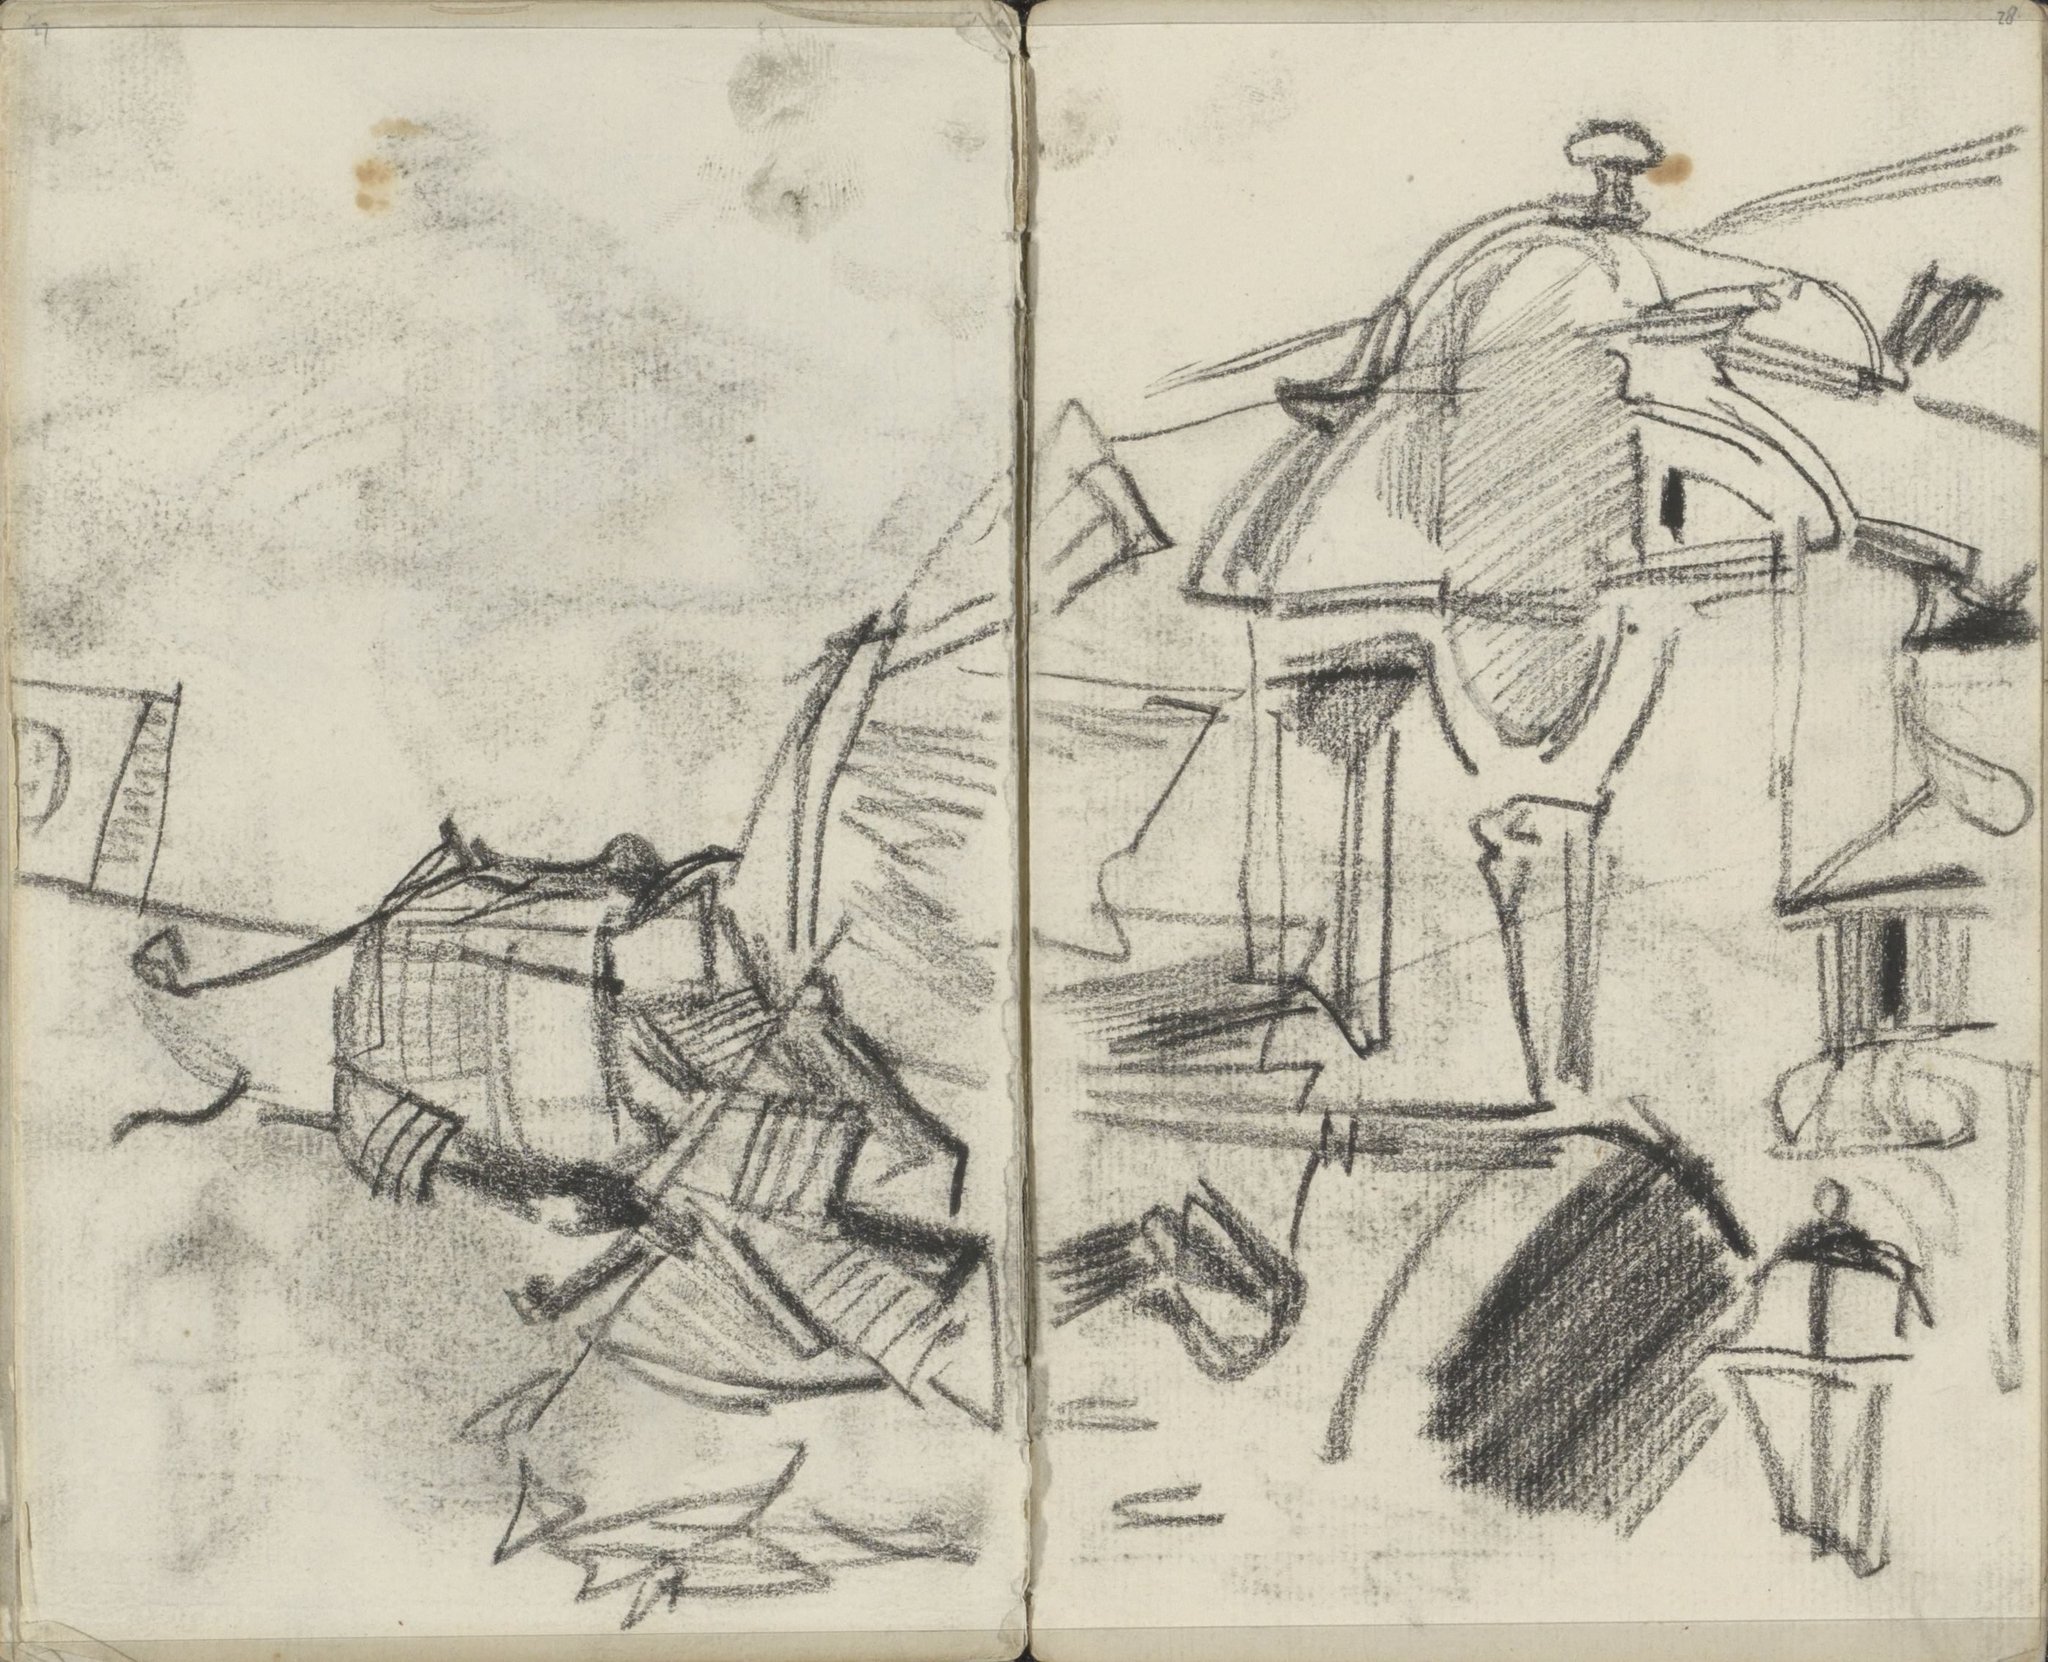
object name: sketchbook leaf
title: Studieblad met een ruiter in harnas, een straatlantaarn en mogelijk een architectuurstudie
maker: george hendrik breitner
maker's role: draughtsman, painter, print maker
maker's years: 1857-1923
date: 1884-1886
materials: chalk, paper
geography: paris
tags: riding a horse, ass, or mule; rider, horseman, architectural detail, armour, street lighting, knight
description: De ruiter, mogelijk een ridder, houdt een banier vast. Pagina 27 en pagina 28 uit een schetsboek met 25 bladen.